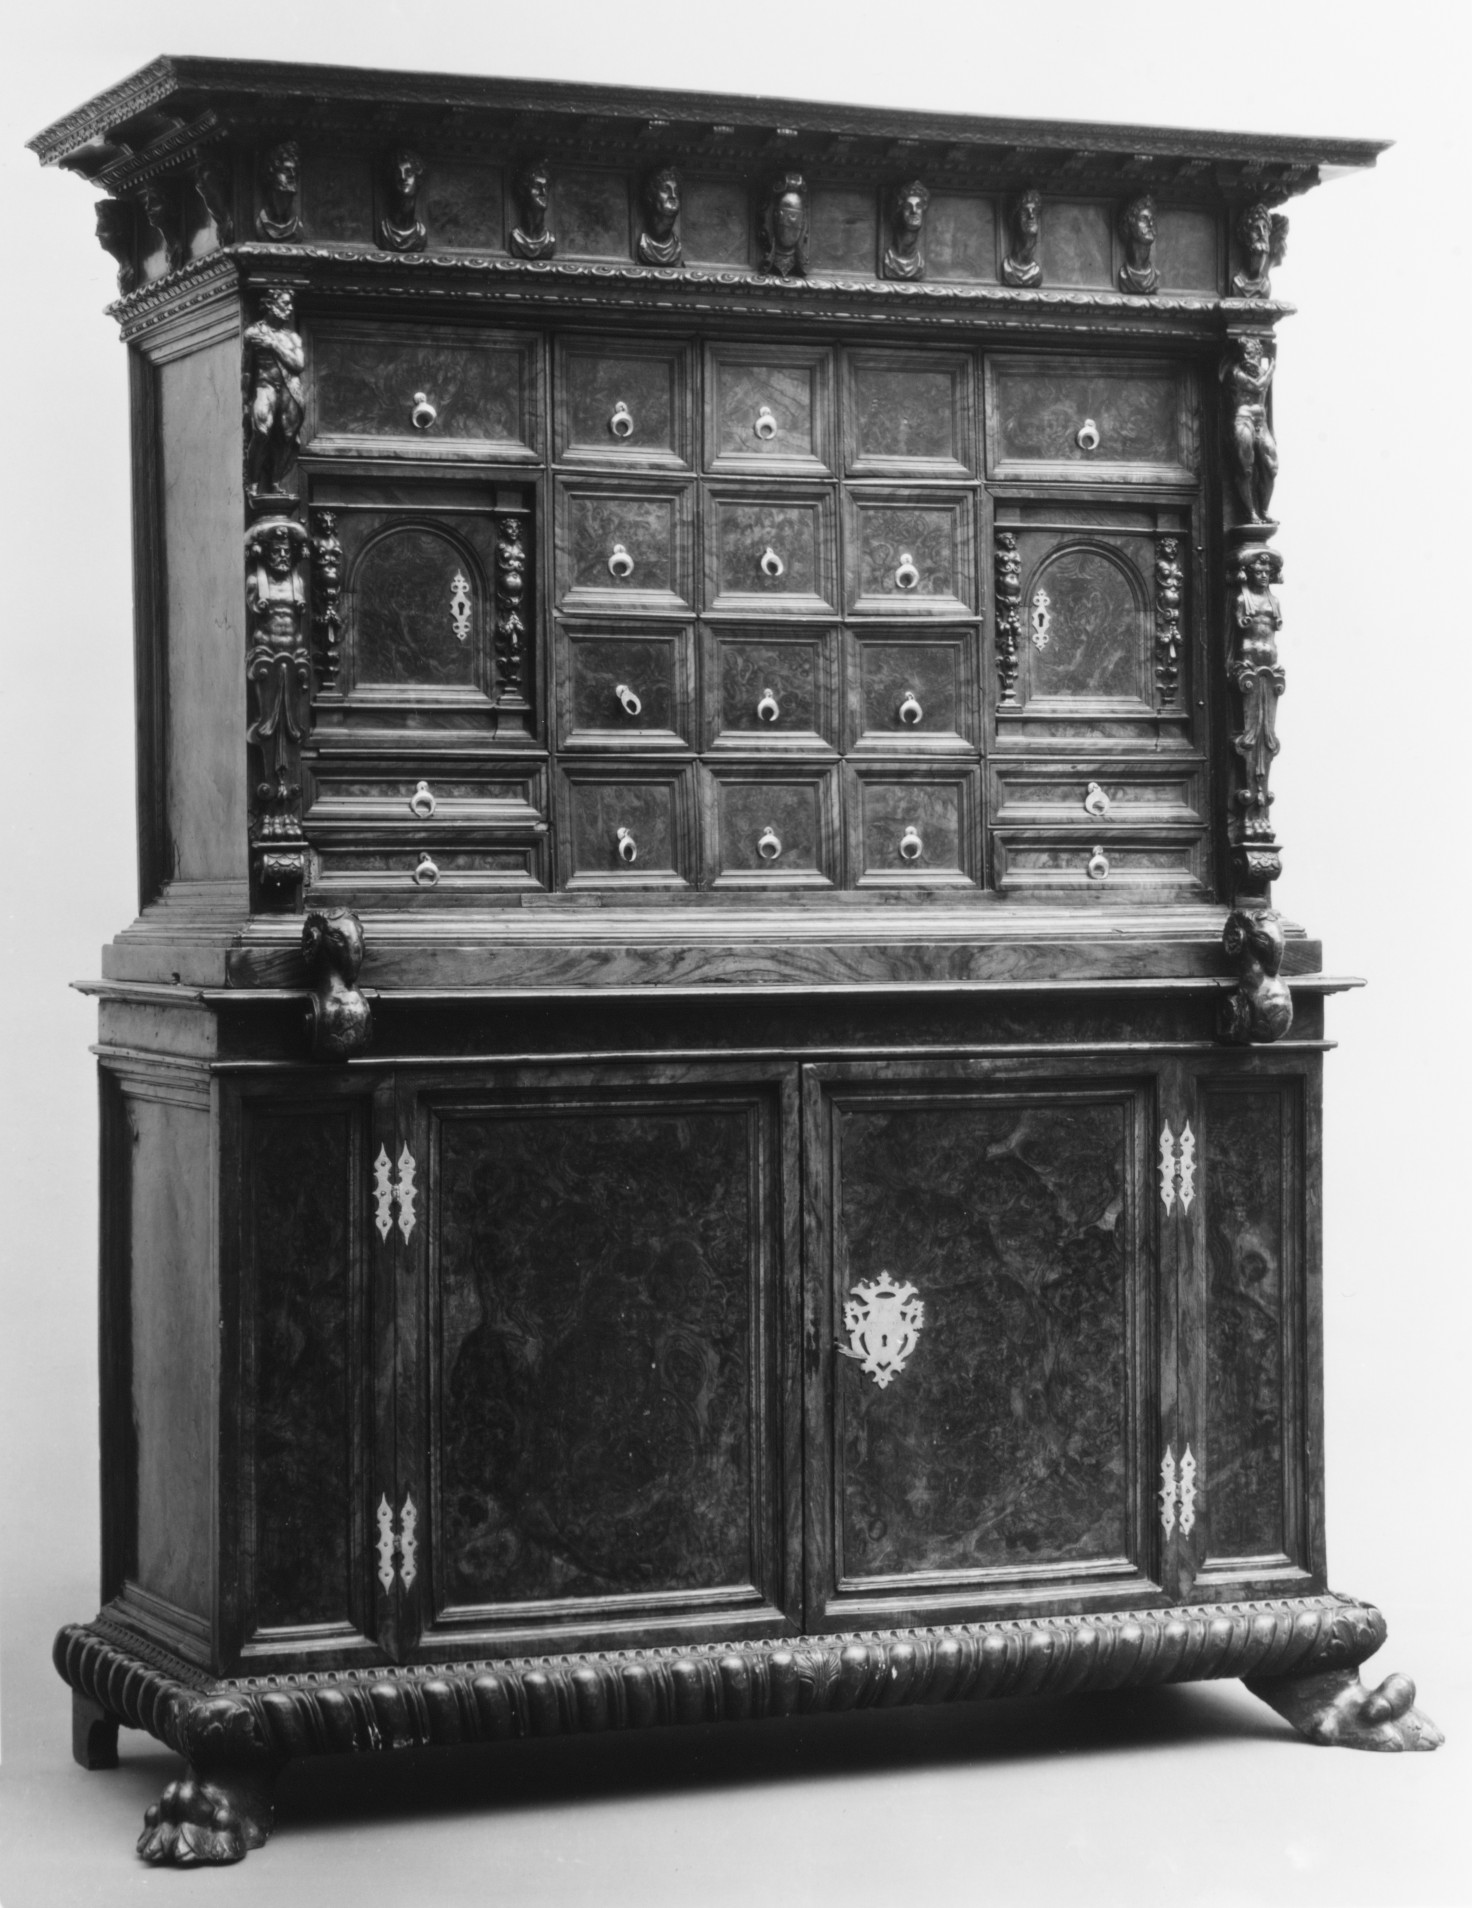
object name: writing cabinet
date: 1567-1633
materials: brass, wood